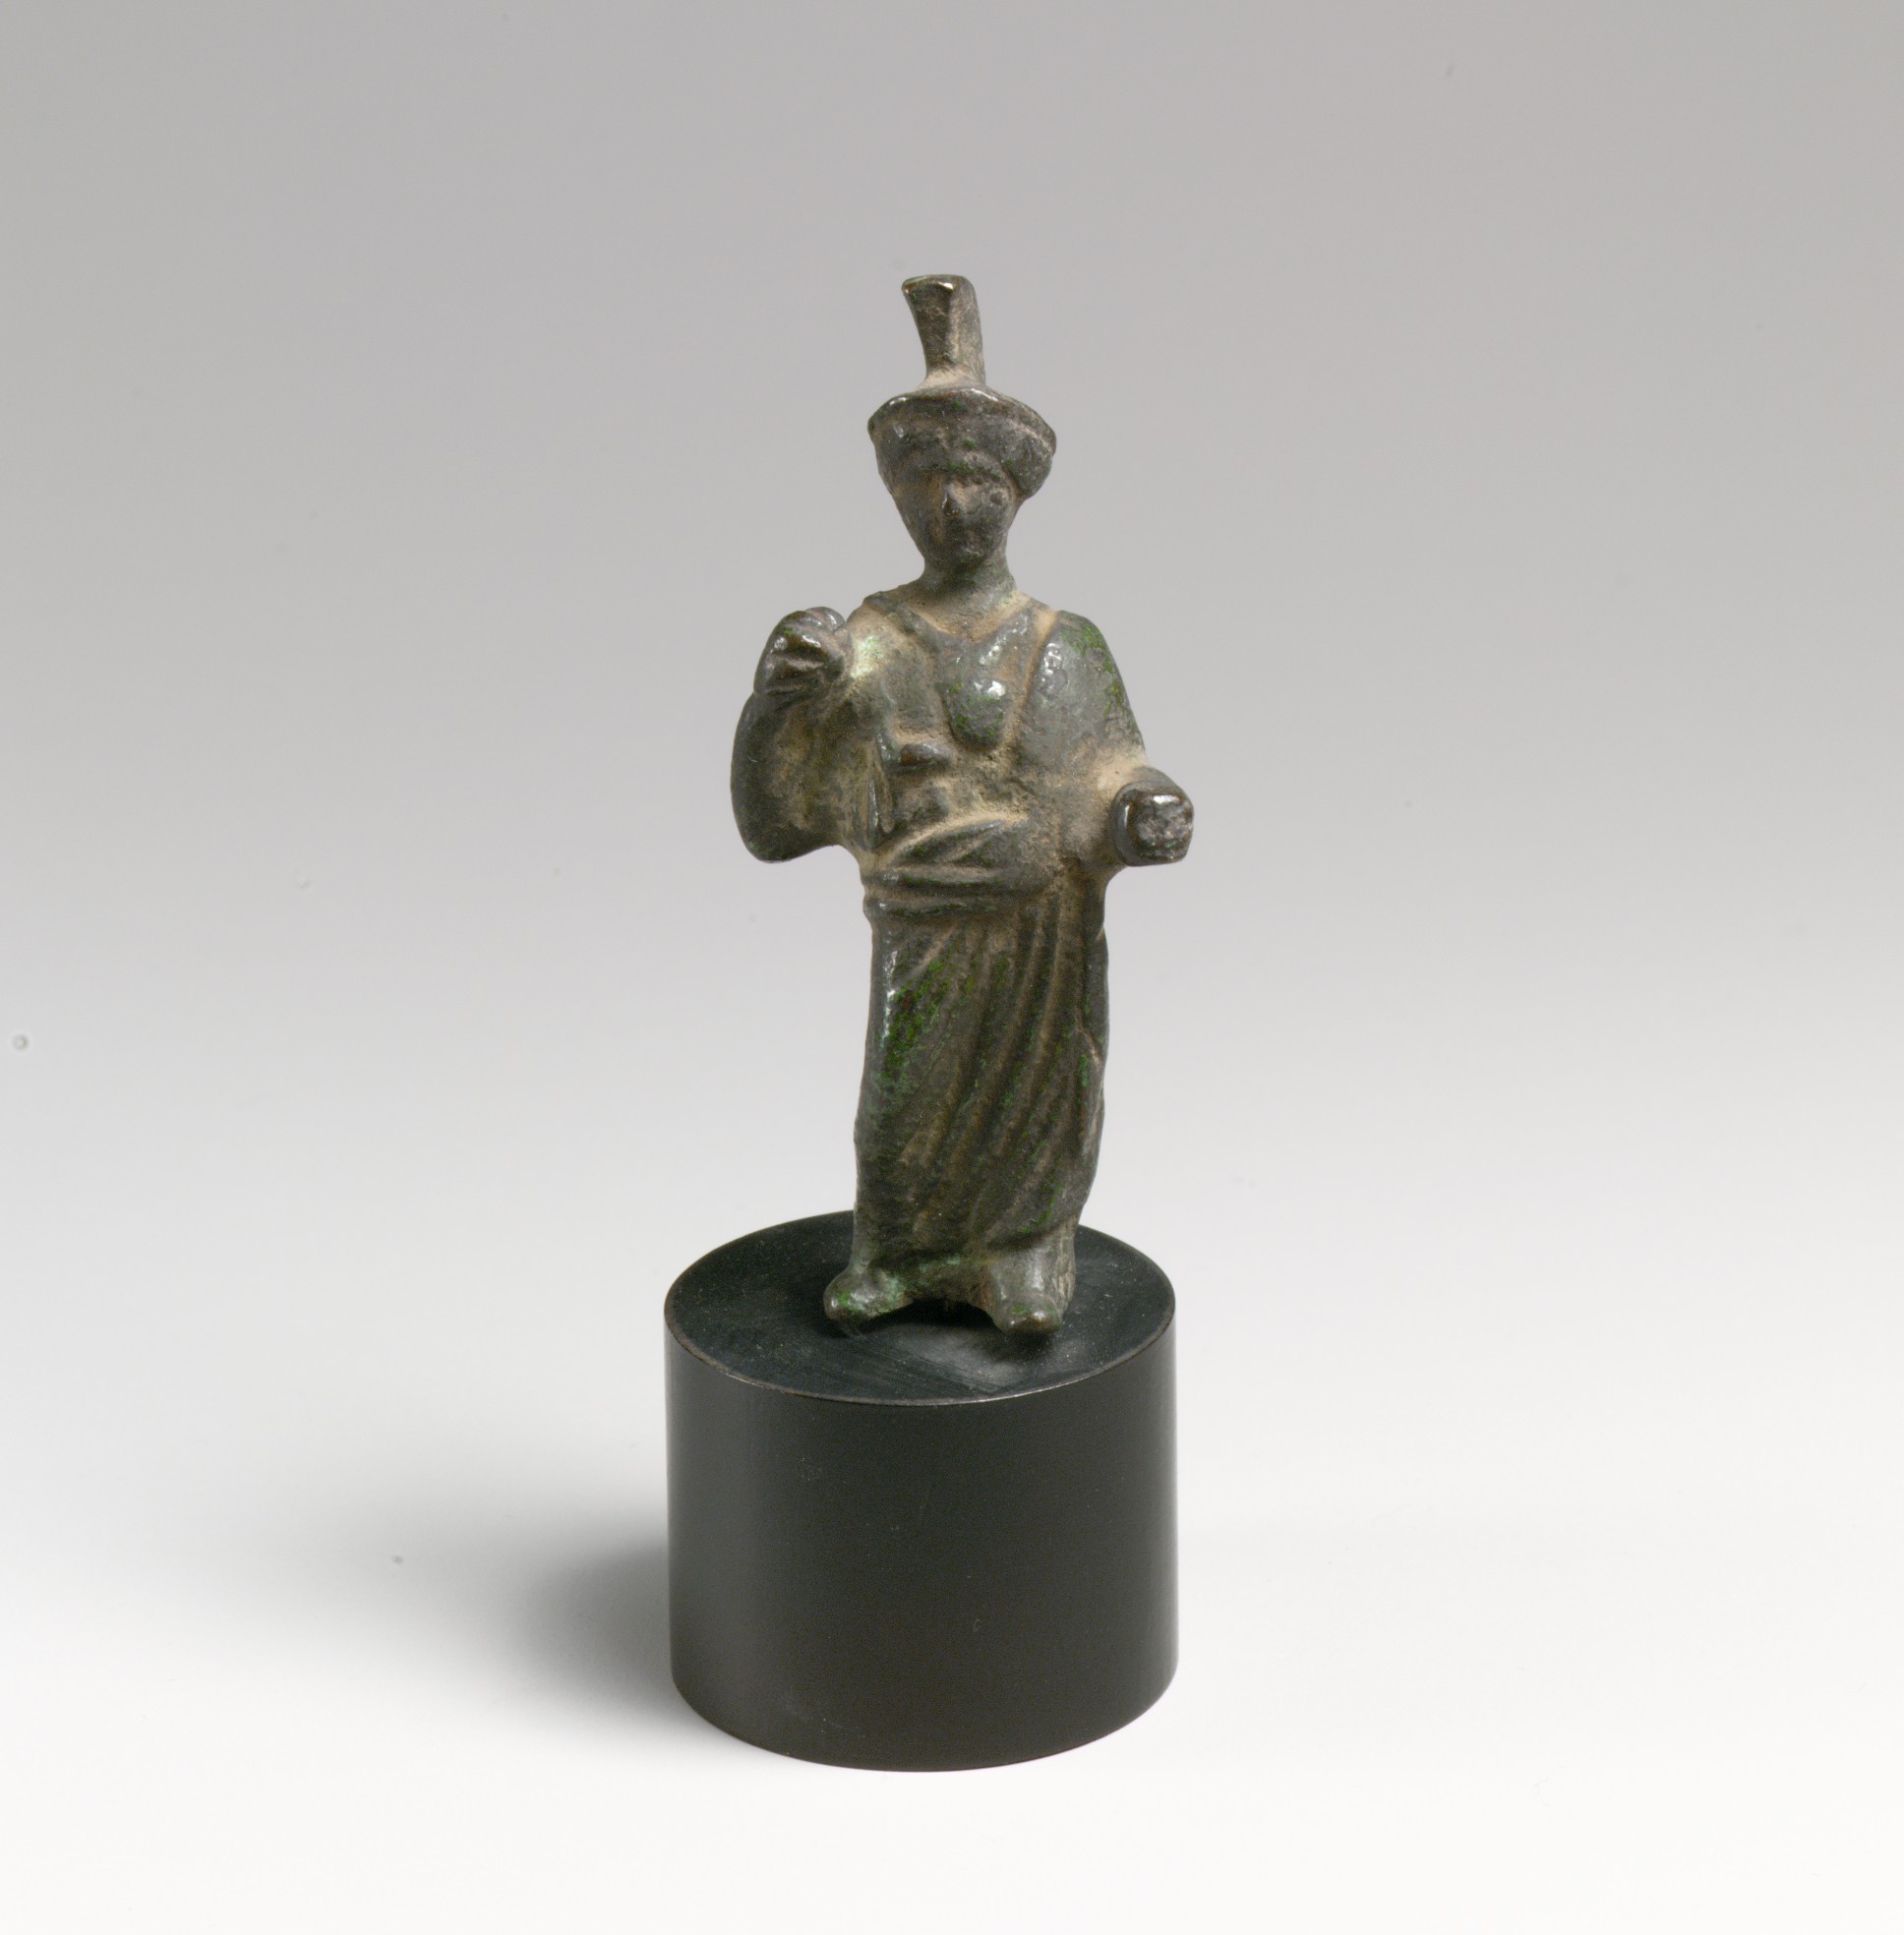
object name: statuette of athena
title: Bronze statuette of Minerva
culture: roman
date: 1-300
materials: bronze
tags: minerva